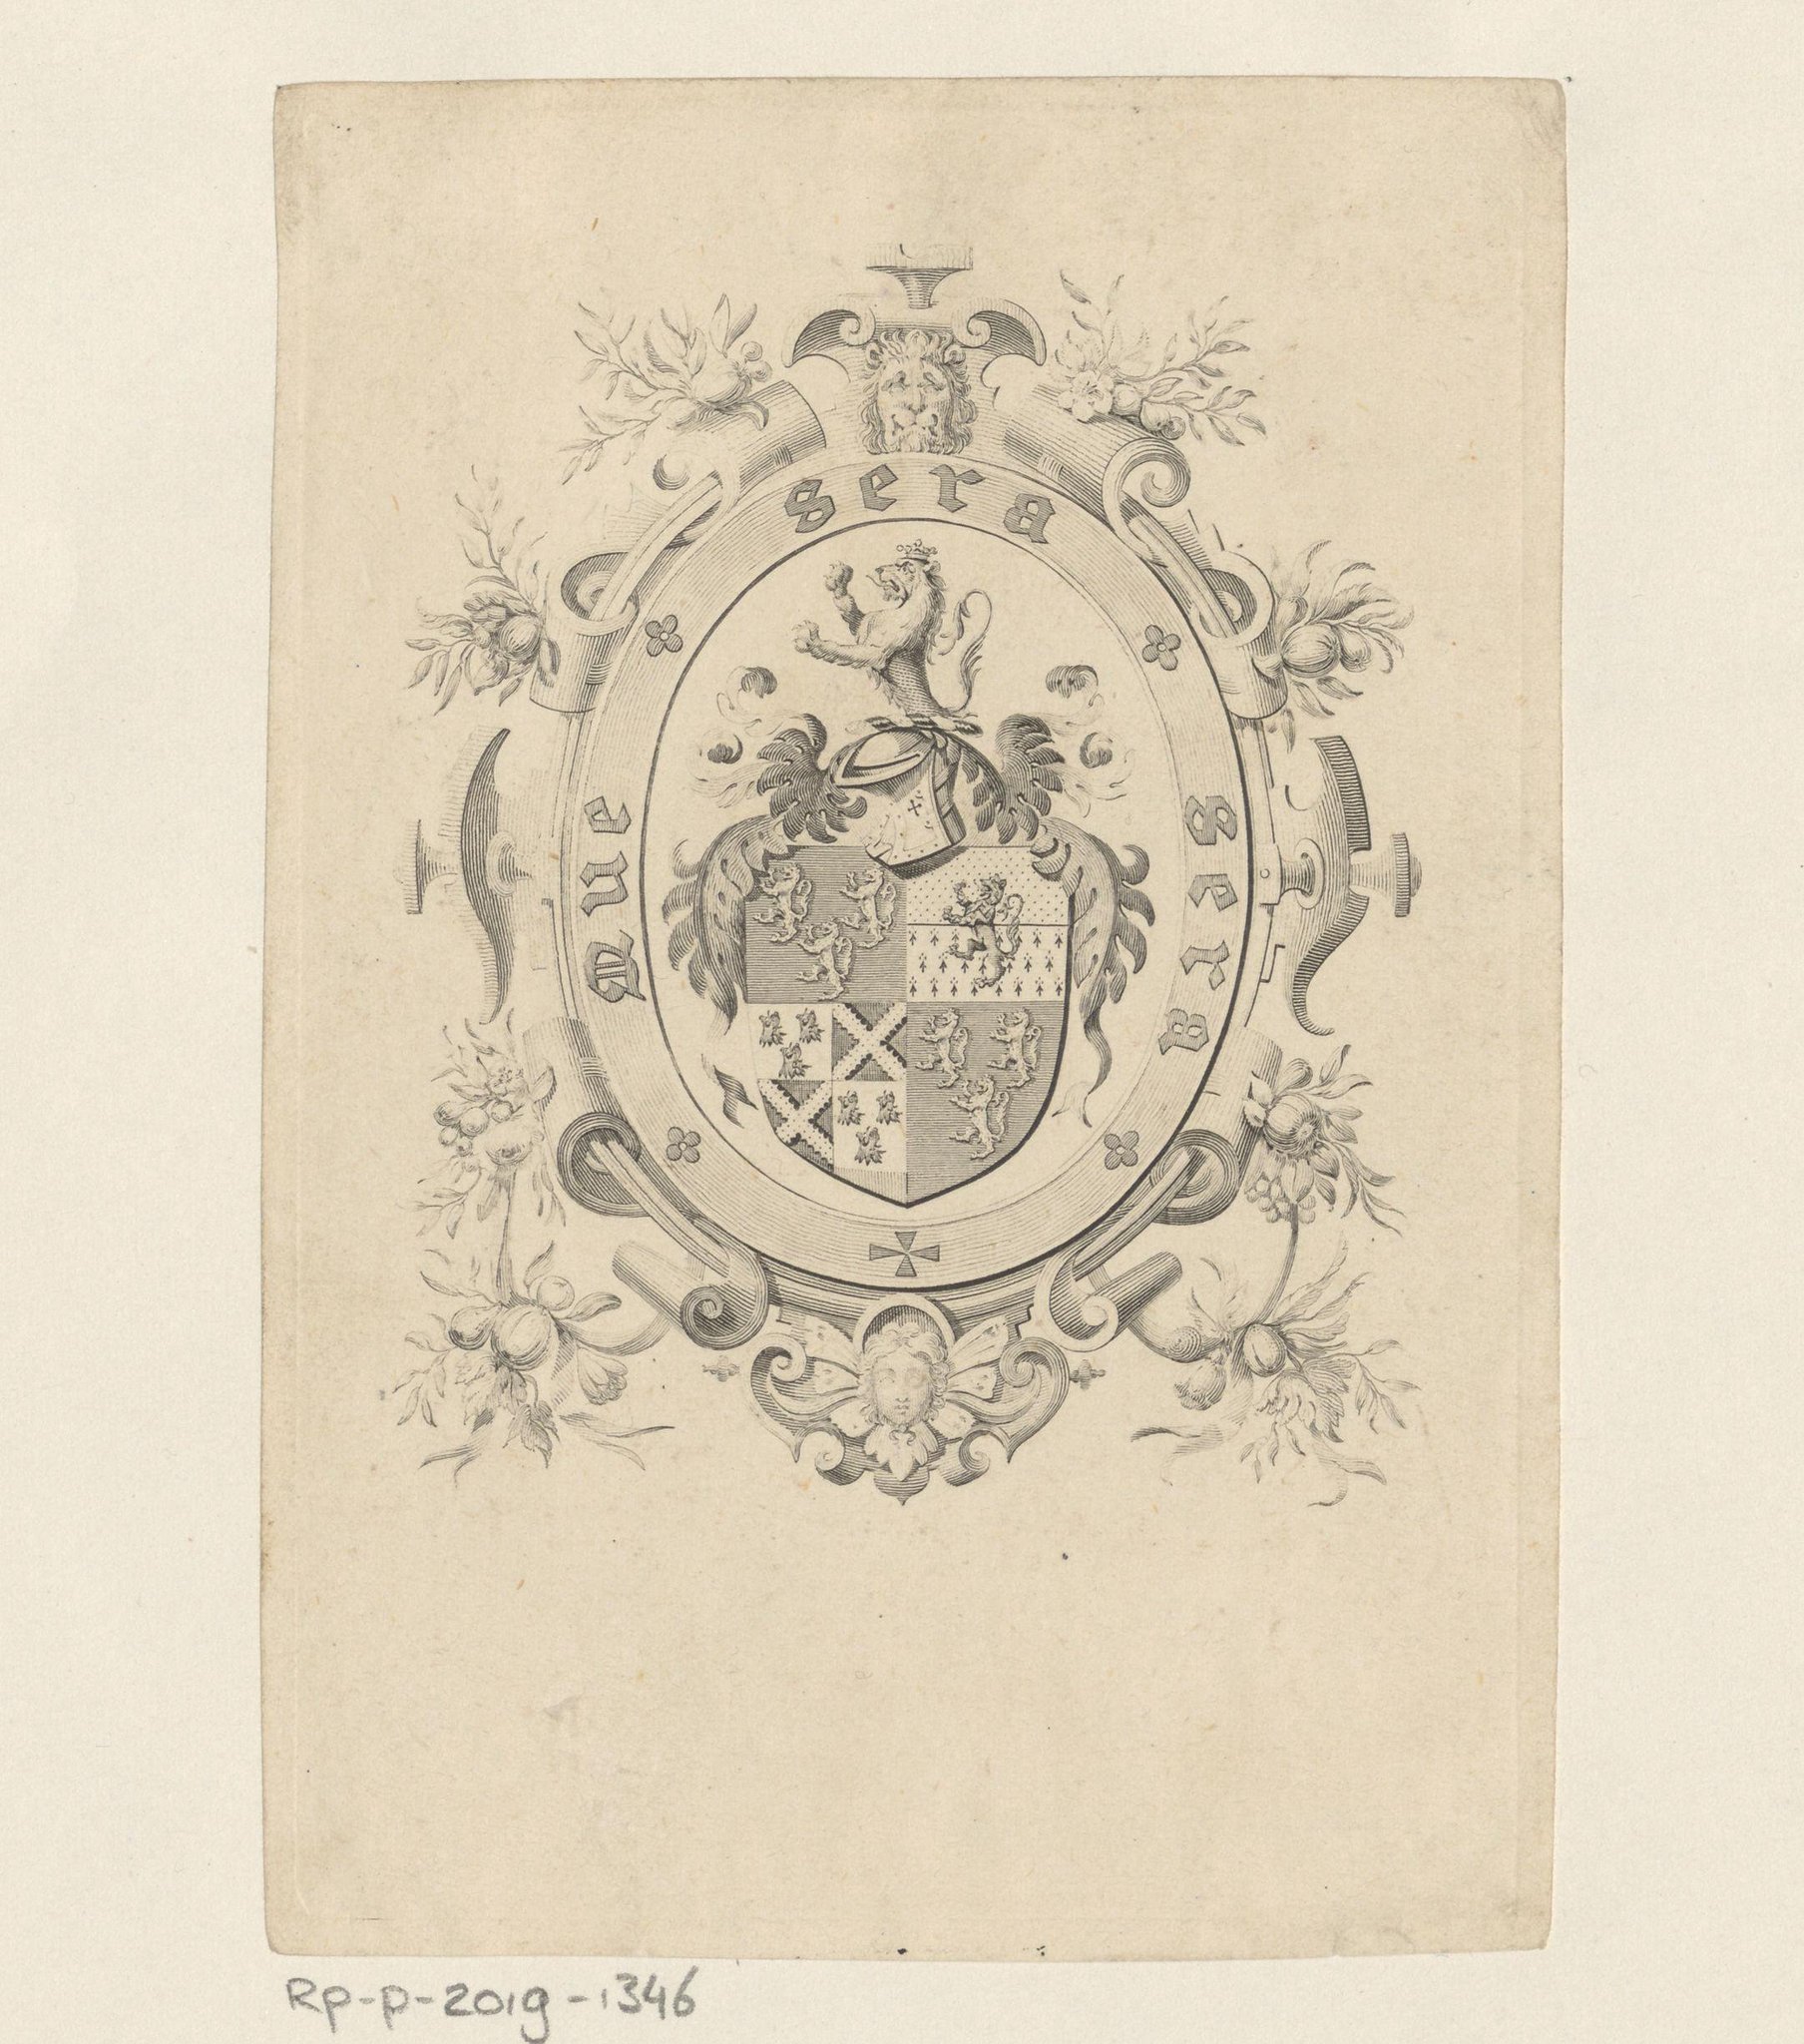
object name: bookplate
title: Ex libris van onbekend, mogelijk R. Ford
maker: Anonymous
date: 1750-1849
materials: paper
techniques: engraving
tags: armorial bearing, heraldry